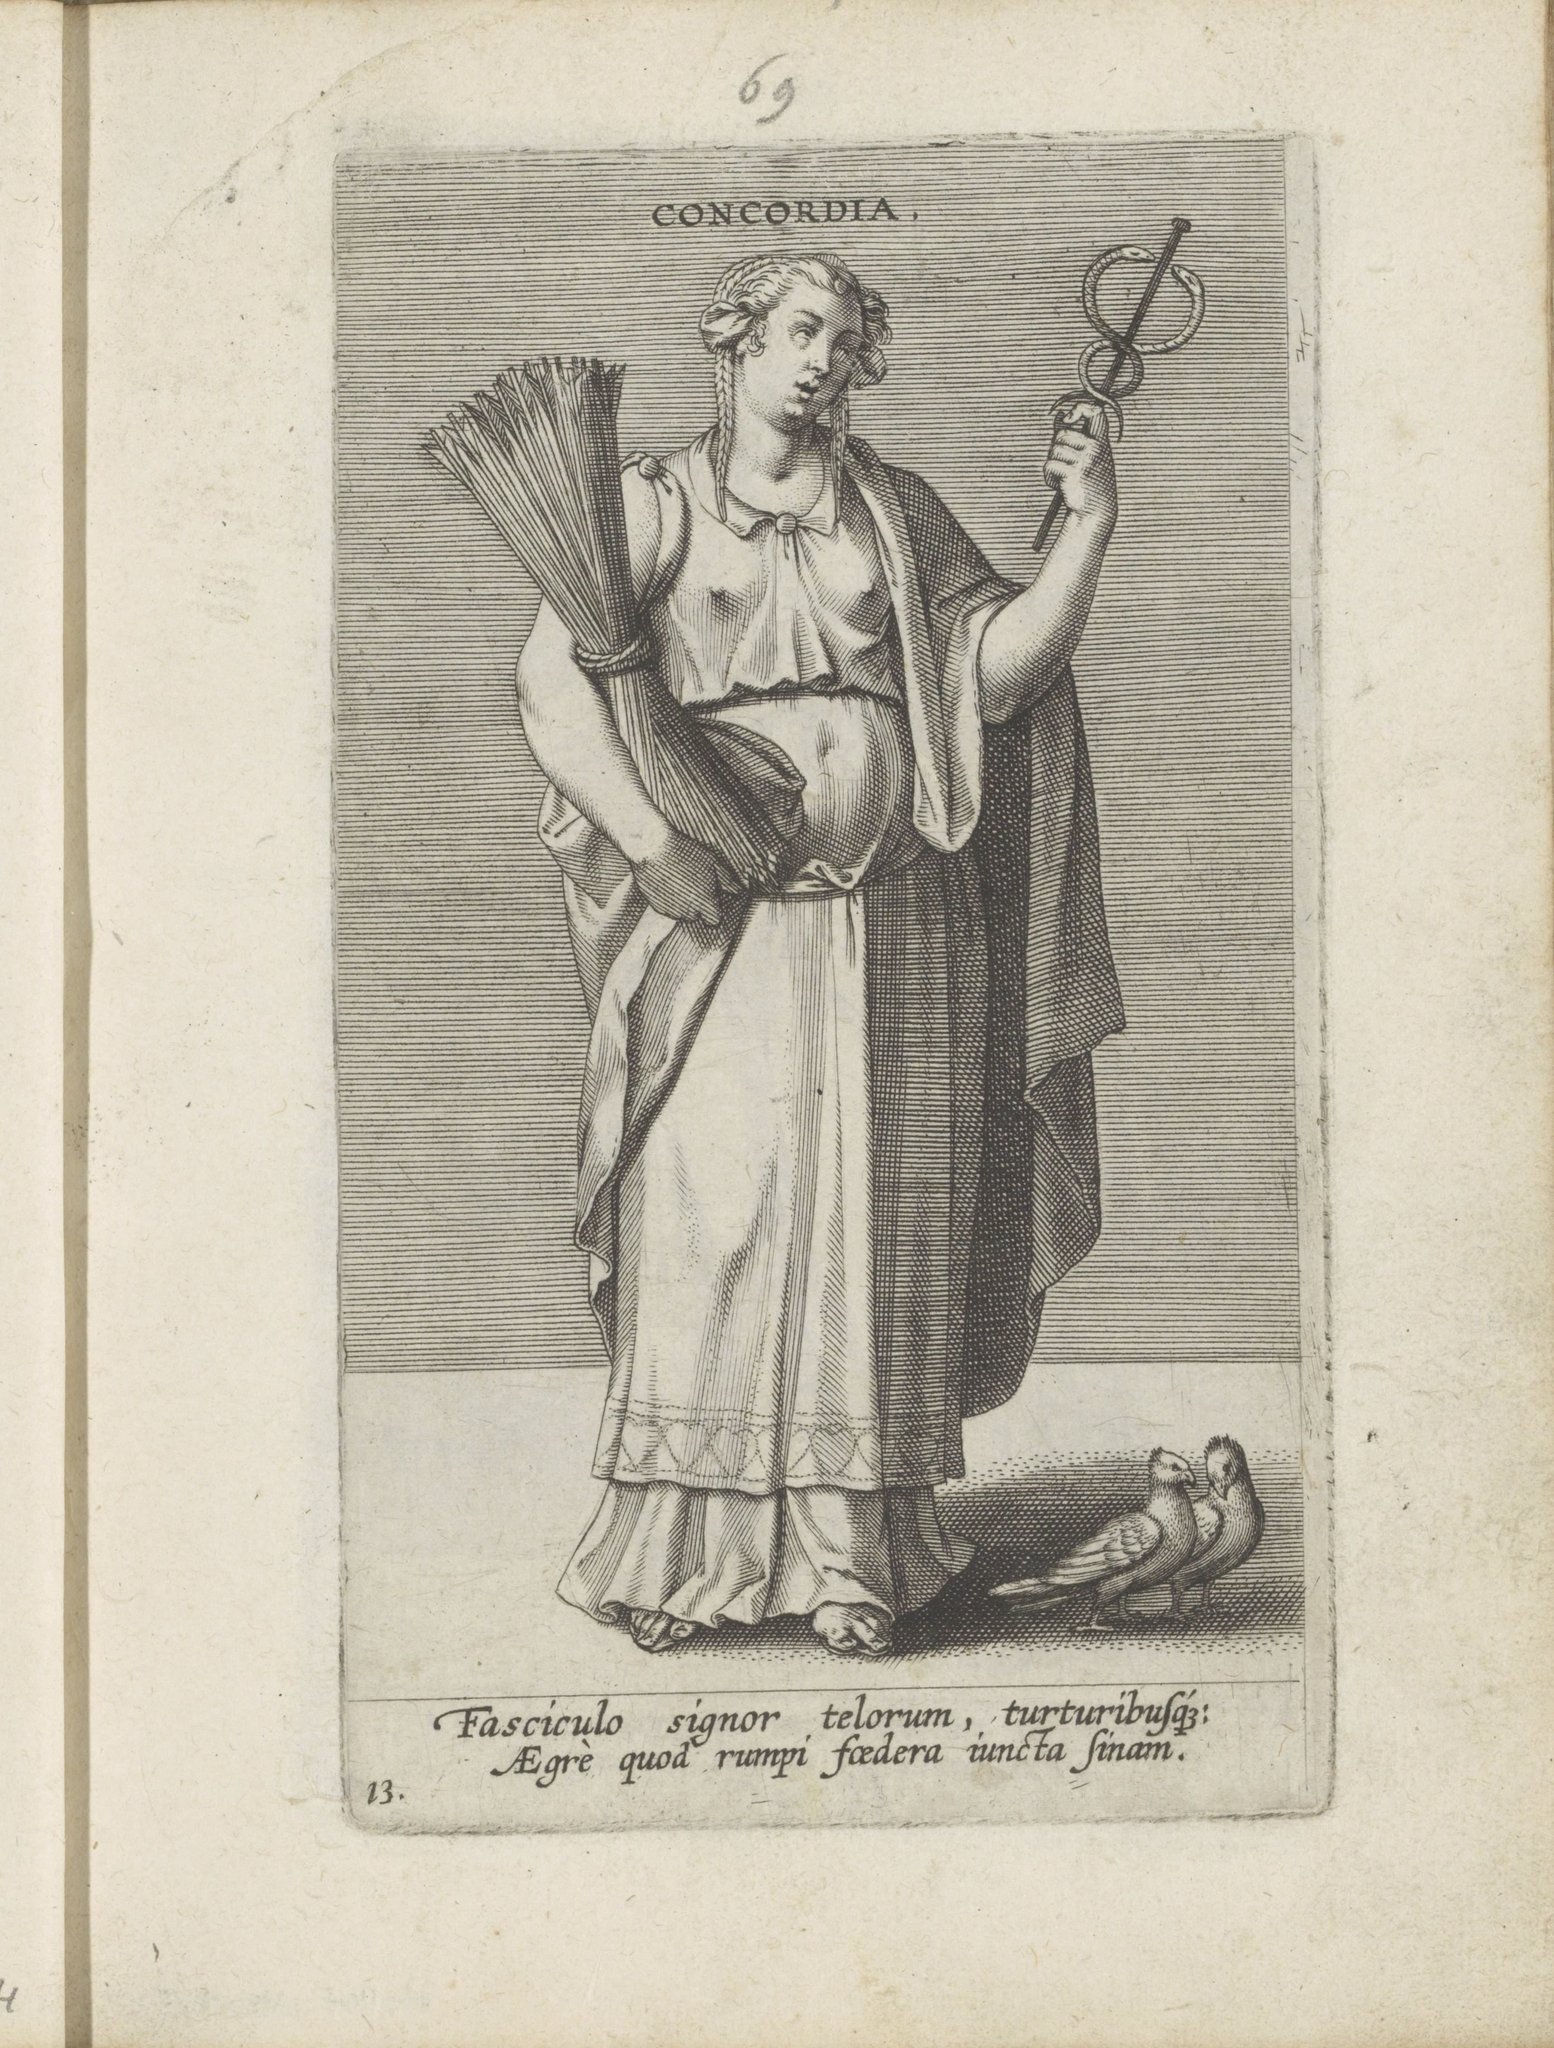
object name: print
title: Concordia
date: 1585-1590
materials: paper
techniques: engraving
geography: antwerp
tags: agreement, unity; 'concordia', 'concordia insuperabile', 'concordia militare', 'concordia di pace', 'unione civile' (ripa), caduceus (staff with two snakes, attribute of mercury), doves, pigeons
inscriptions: collector's mark: Lugt 2228, collector's mark: Lugt 2760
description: Staande vrouw met aan haar voeten twee elkaar aankijkende duiven. In haar linkerhand houdt zij een caduceus vast, op haar rechterarm draagt zij een schoof koren. Onder de voorstelling twee prenten in het Latijn. De prent maakt deel uit van een album.